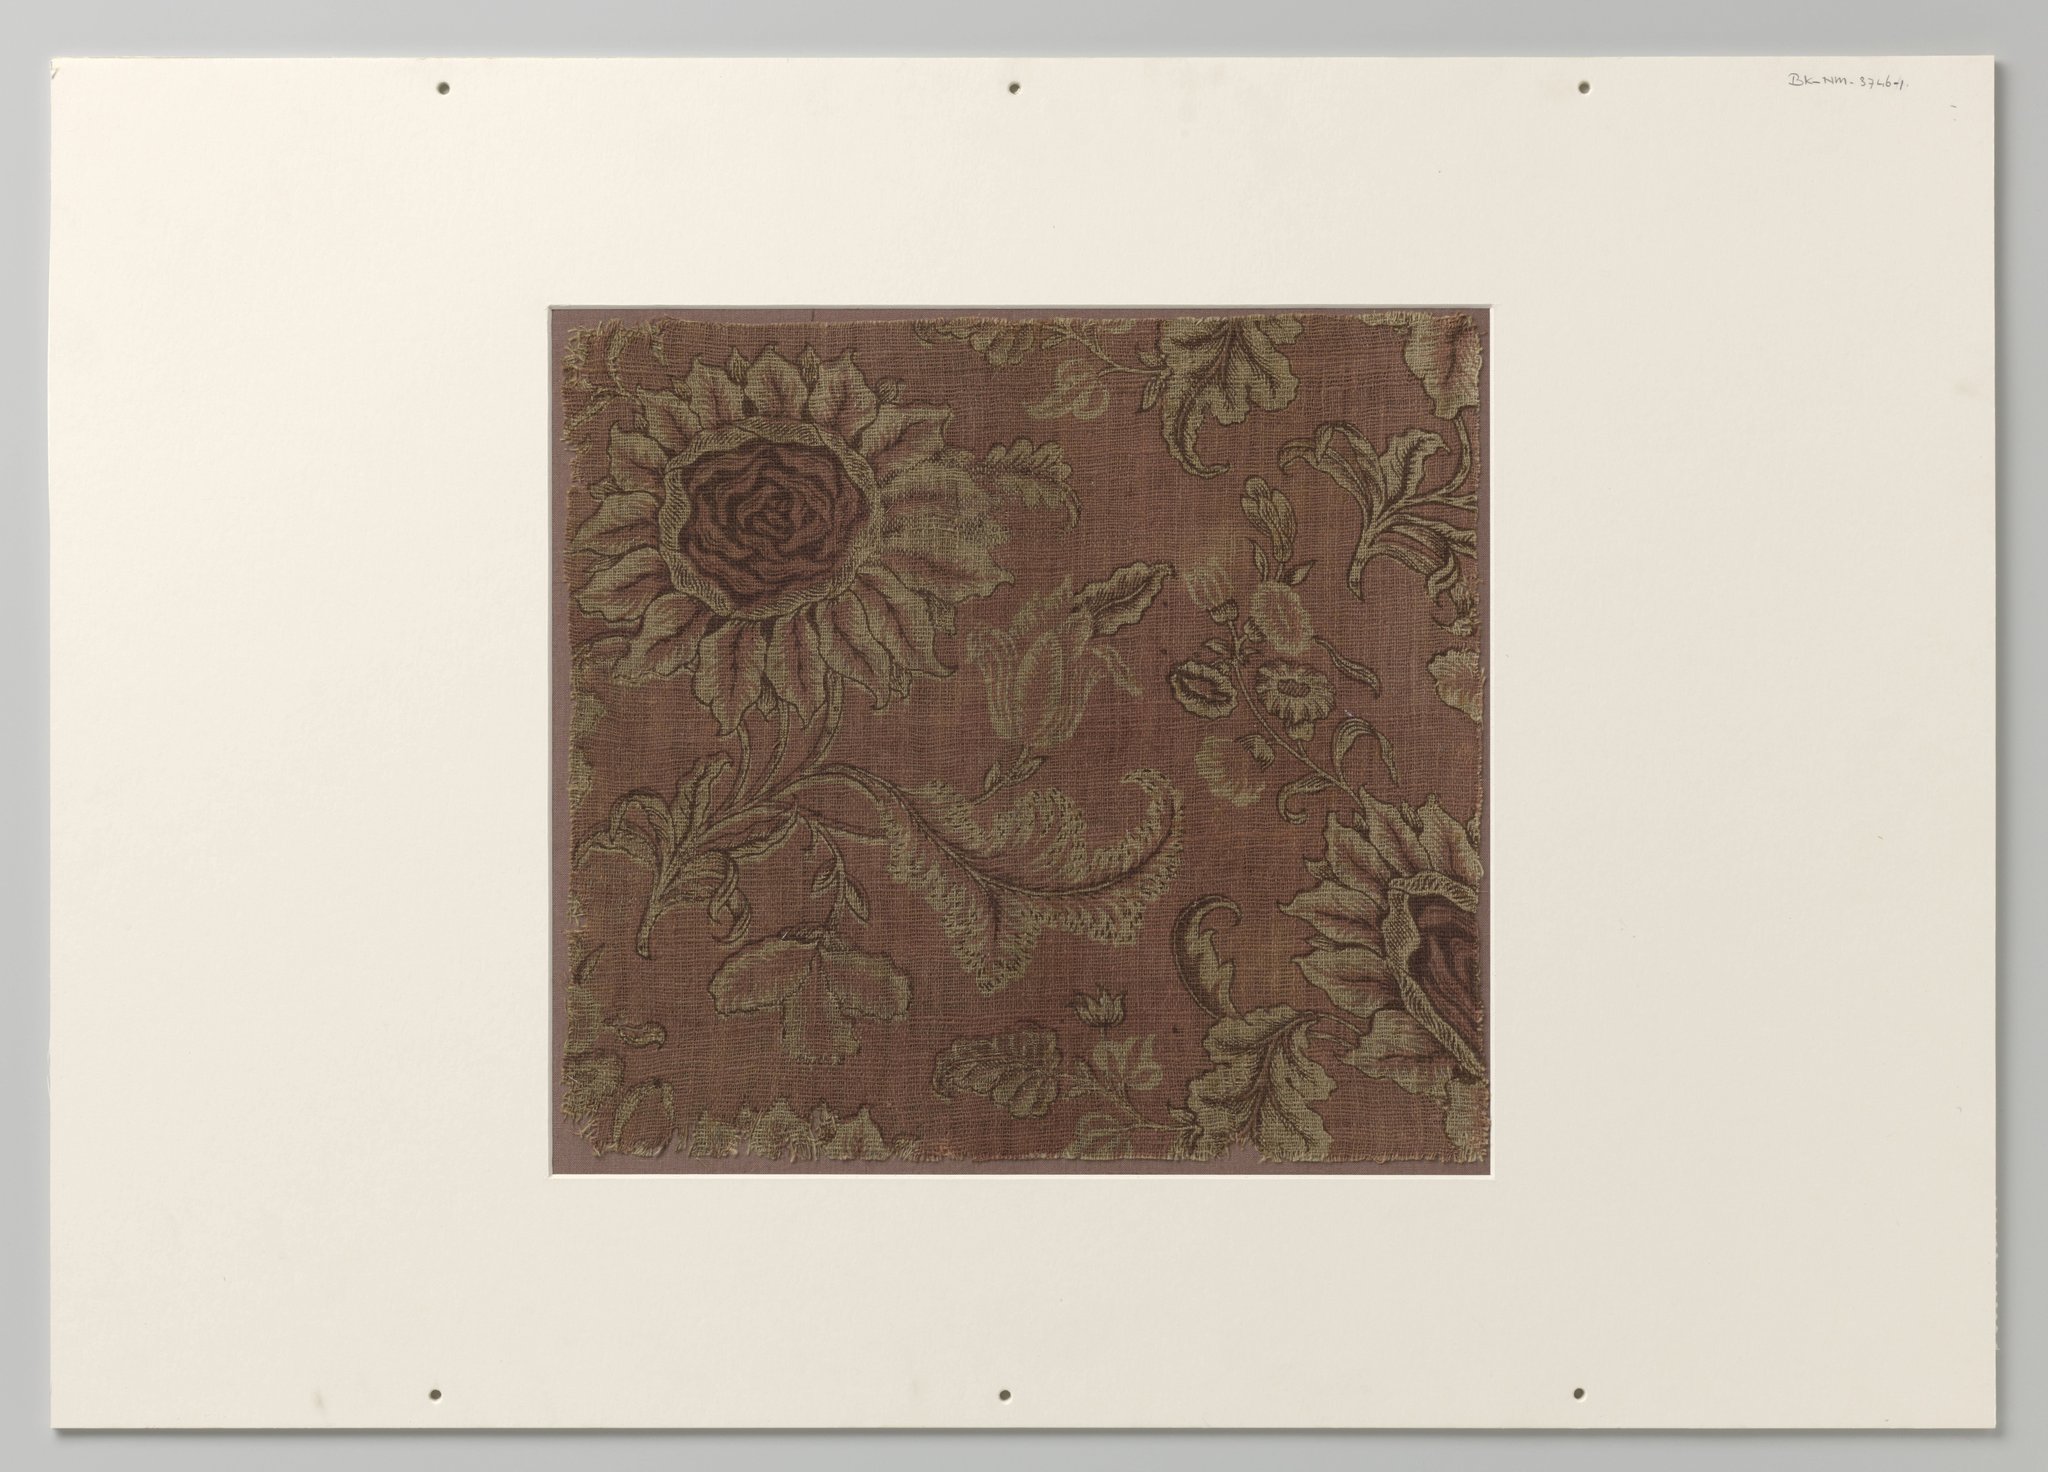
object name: woven material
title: Fragment grof linnenweefsel, rode grond, bloemen van geel en bruin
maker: Anonymous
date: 1750-1825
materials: linen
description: Fragment grof linnen weefsel, rode grond, bloemen van geel en bruin. Duitsland.